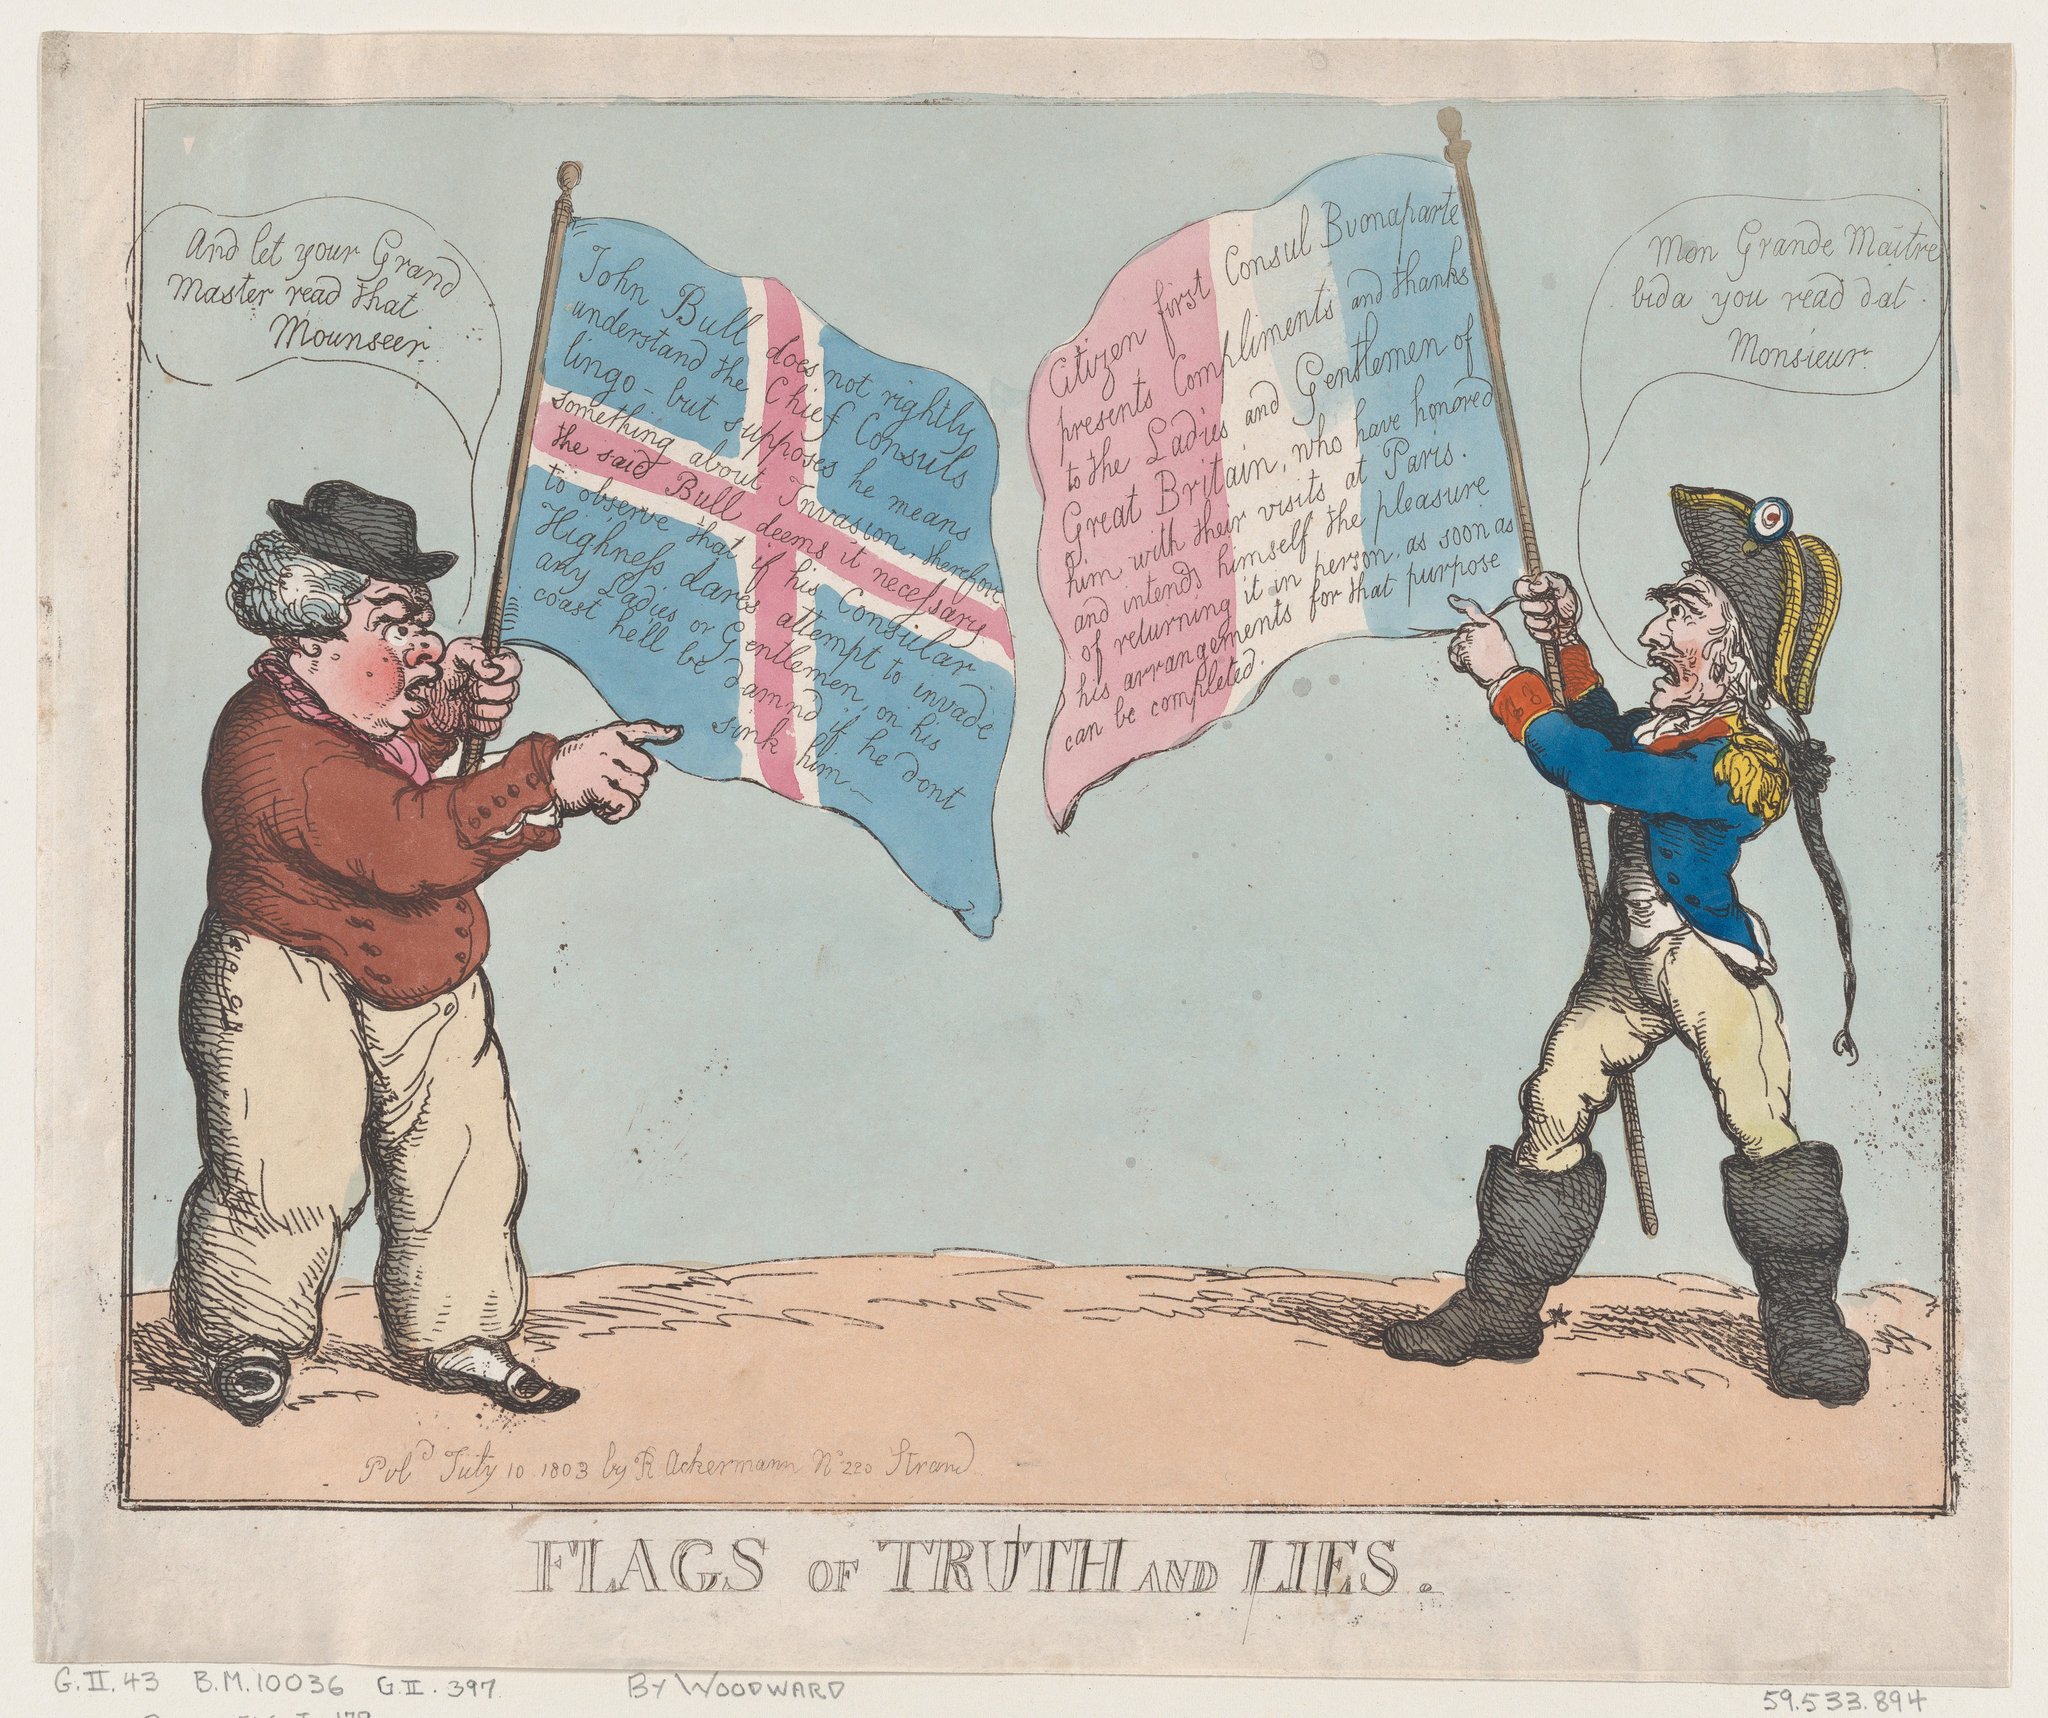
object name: print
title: Flags of Truth and Lies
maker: thomas rowlandson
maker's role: artist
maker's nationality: british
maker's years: 1757-1827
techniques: etching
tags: satire,soldiers,men,flags